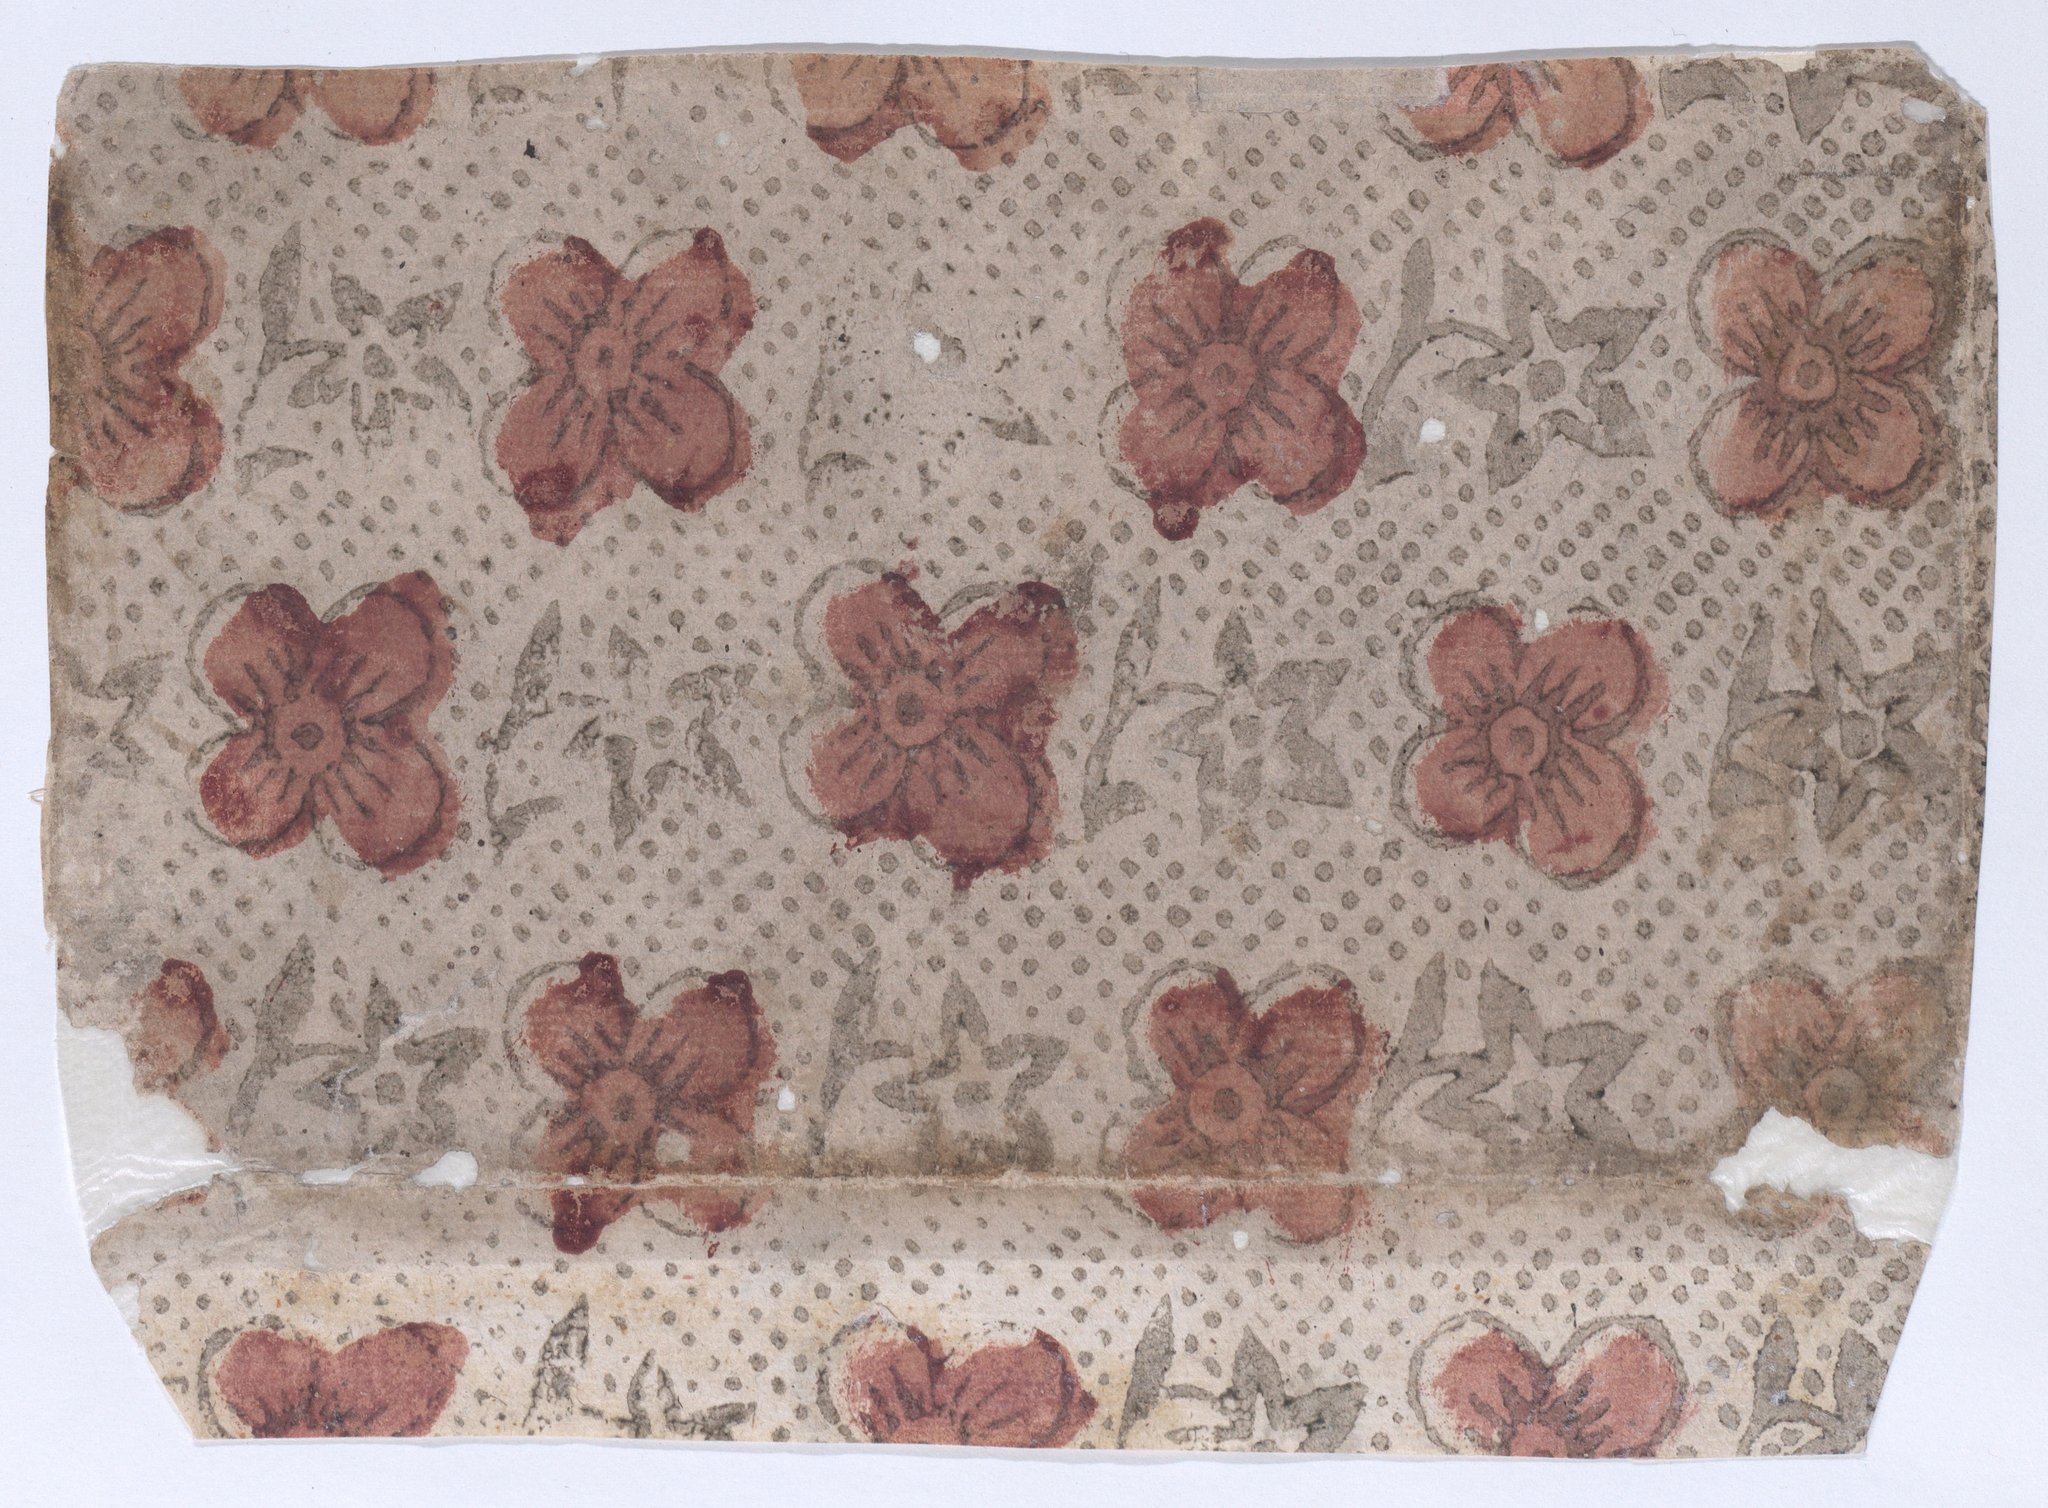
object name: print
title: Sheet with overall floral and dot pattern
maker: Anonymous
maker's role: artist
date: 1801-1900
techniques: relief print